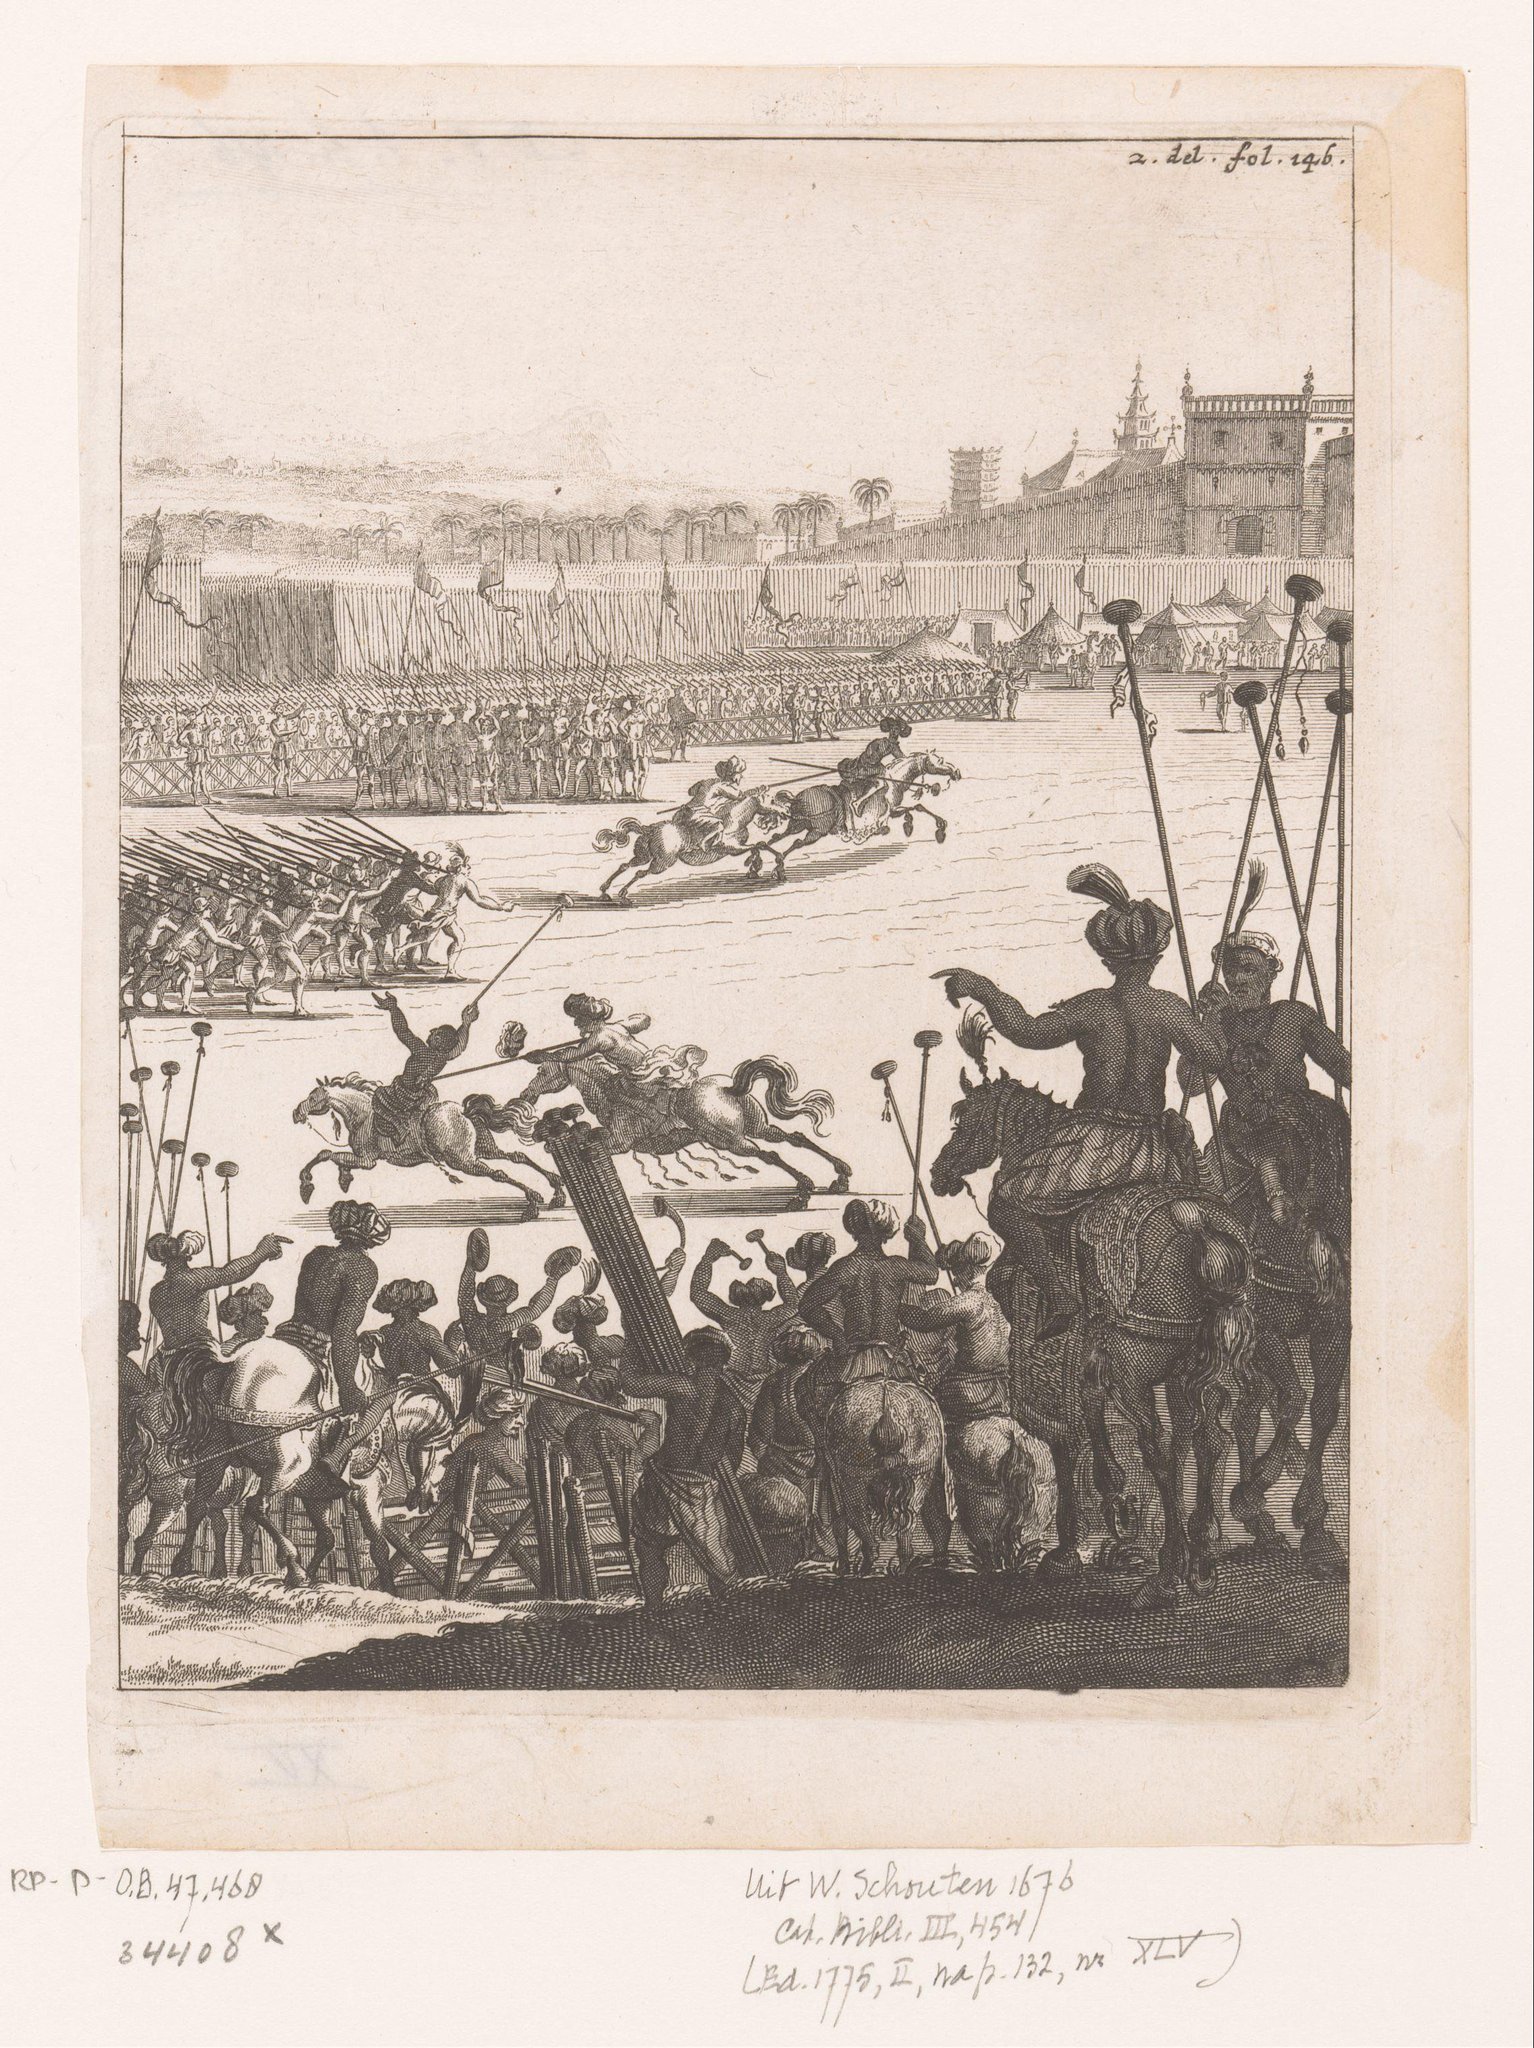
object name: book illustration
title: Koninklijk toernooi op Java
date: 1676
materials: paper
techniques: engraving, etching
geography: amsterdam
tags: mataram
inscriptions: collector's mark: Lugt 2228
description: Prent uit: Schouten, Wouter. Wouter Schoutens Oost-Indische voyagie (...). 2 dln. Amsterdam: Jacob van Meurs en Johannes van Someren, 1676, dl. 2, p. 146-147.